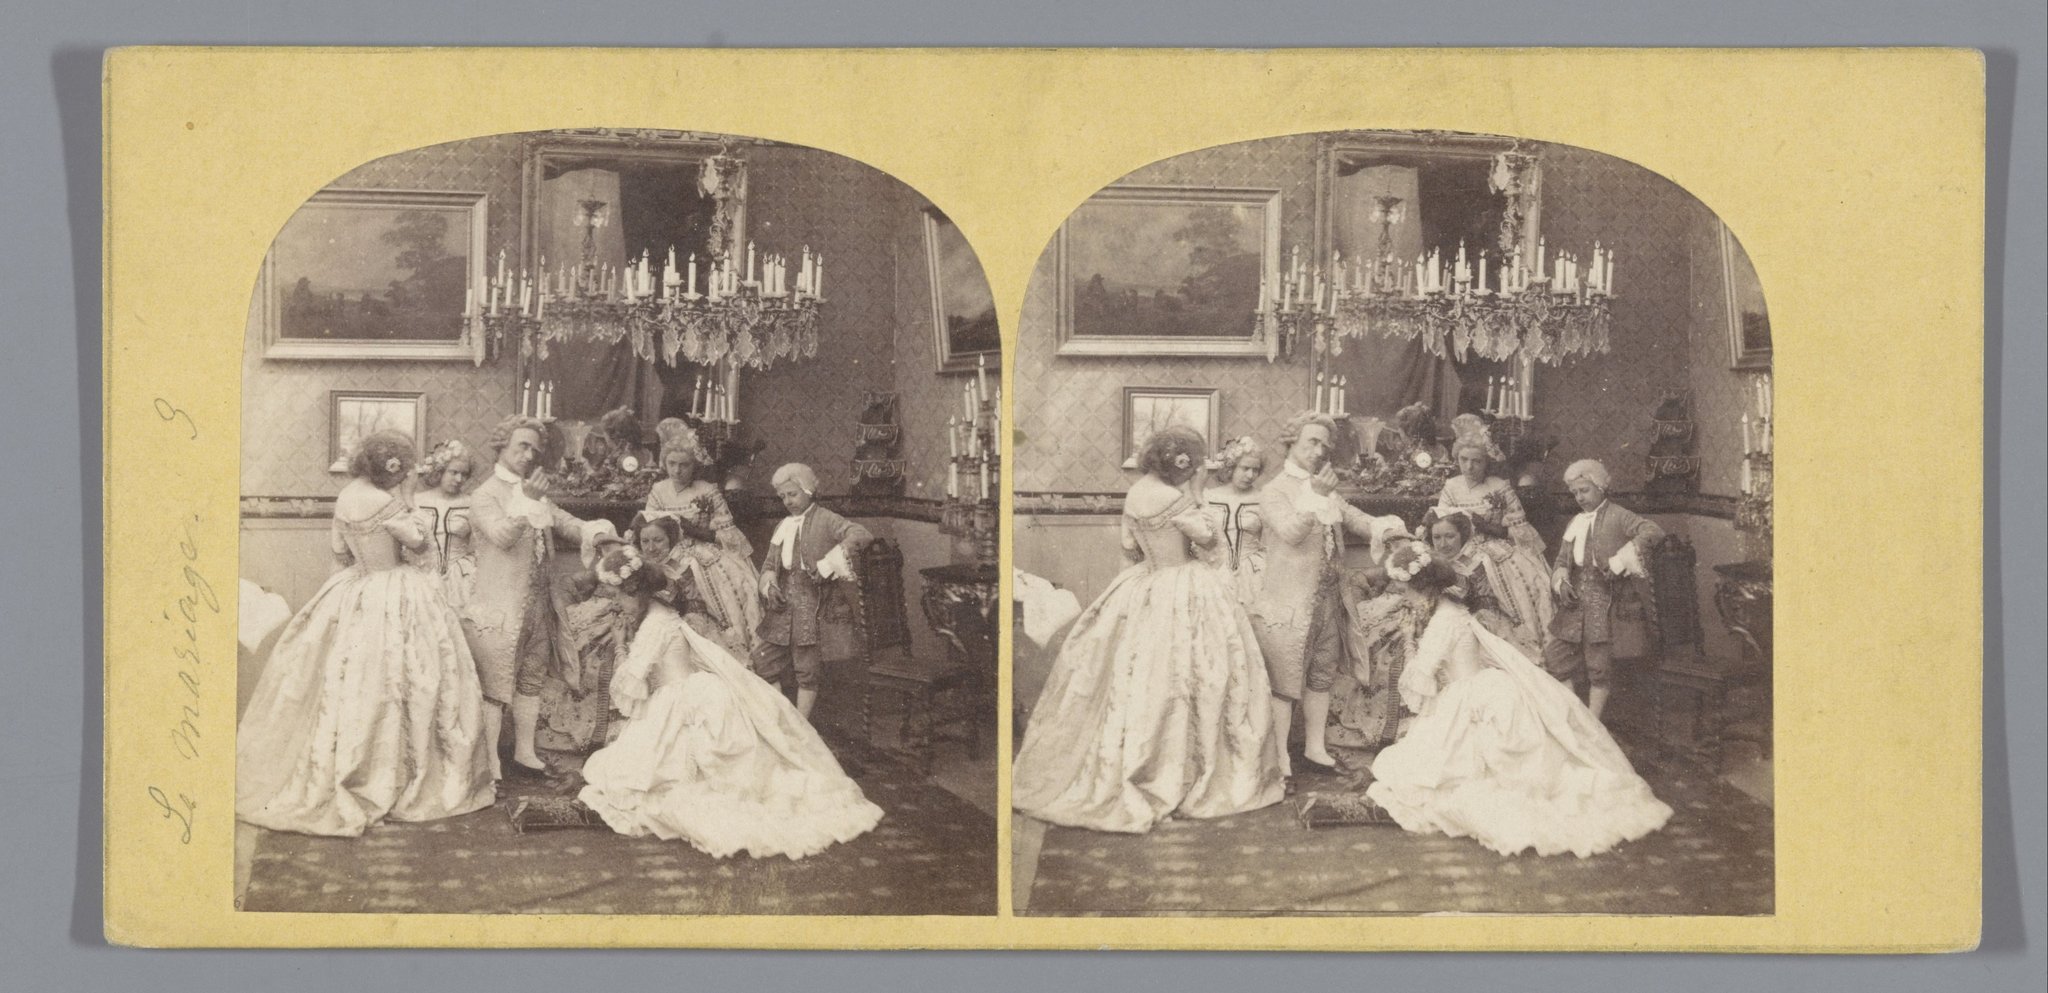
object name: stereograph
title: Voorbereidingen voor een bruiloft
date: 1859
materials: cardboard, paper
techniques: albumen print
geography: paris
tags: parental blessings and admonitions, france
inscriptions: inscription: ‘12 Dec. 1863./ Ven. T.v. Jagtlust./ Marie de Kempenaer.’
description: Waarschijnlijk deel van de serie 'Un mariage sous Louis XV'.